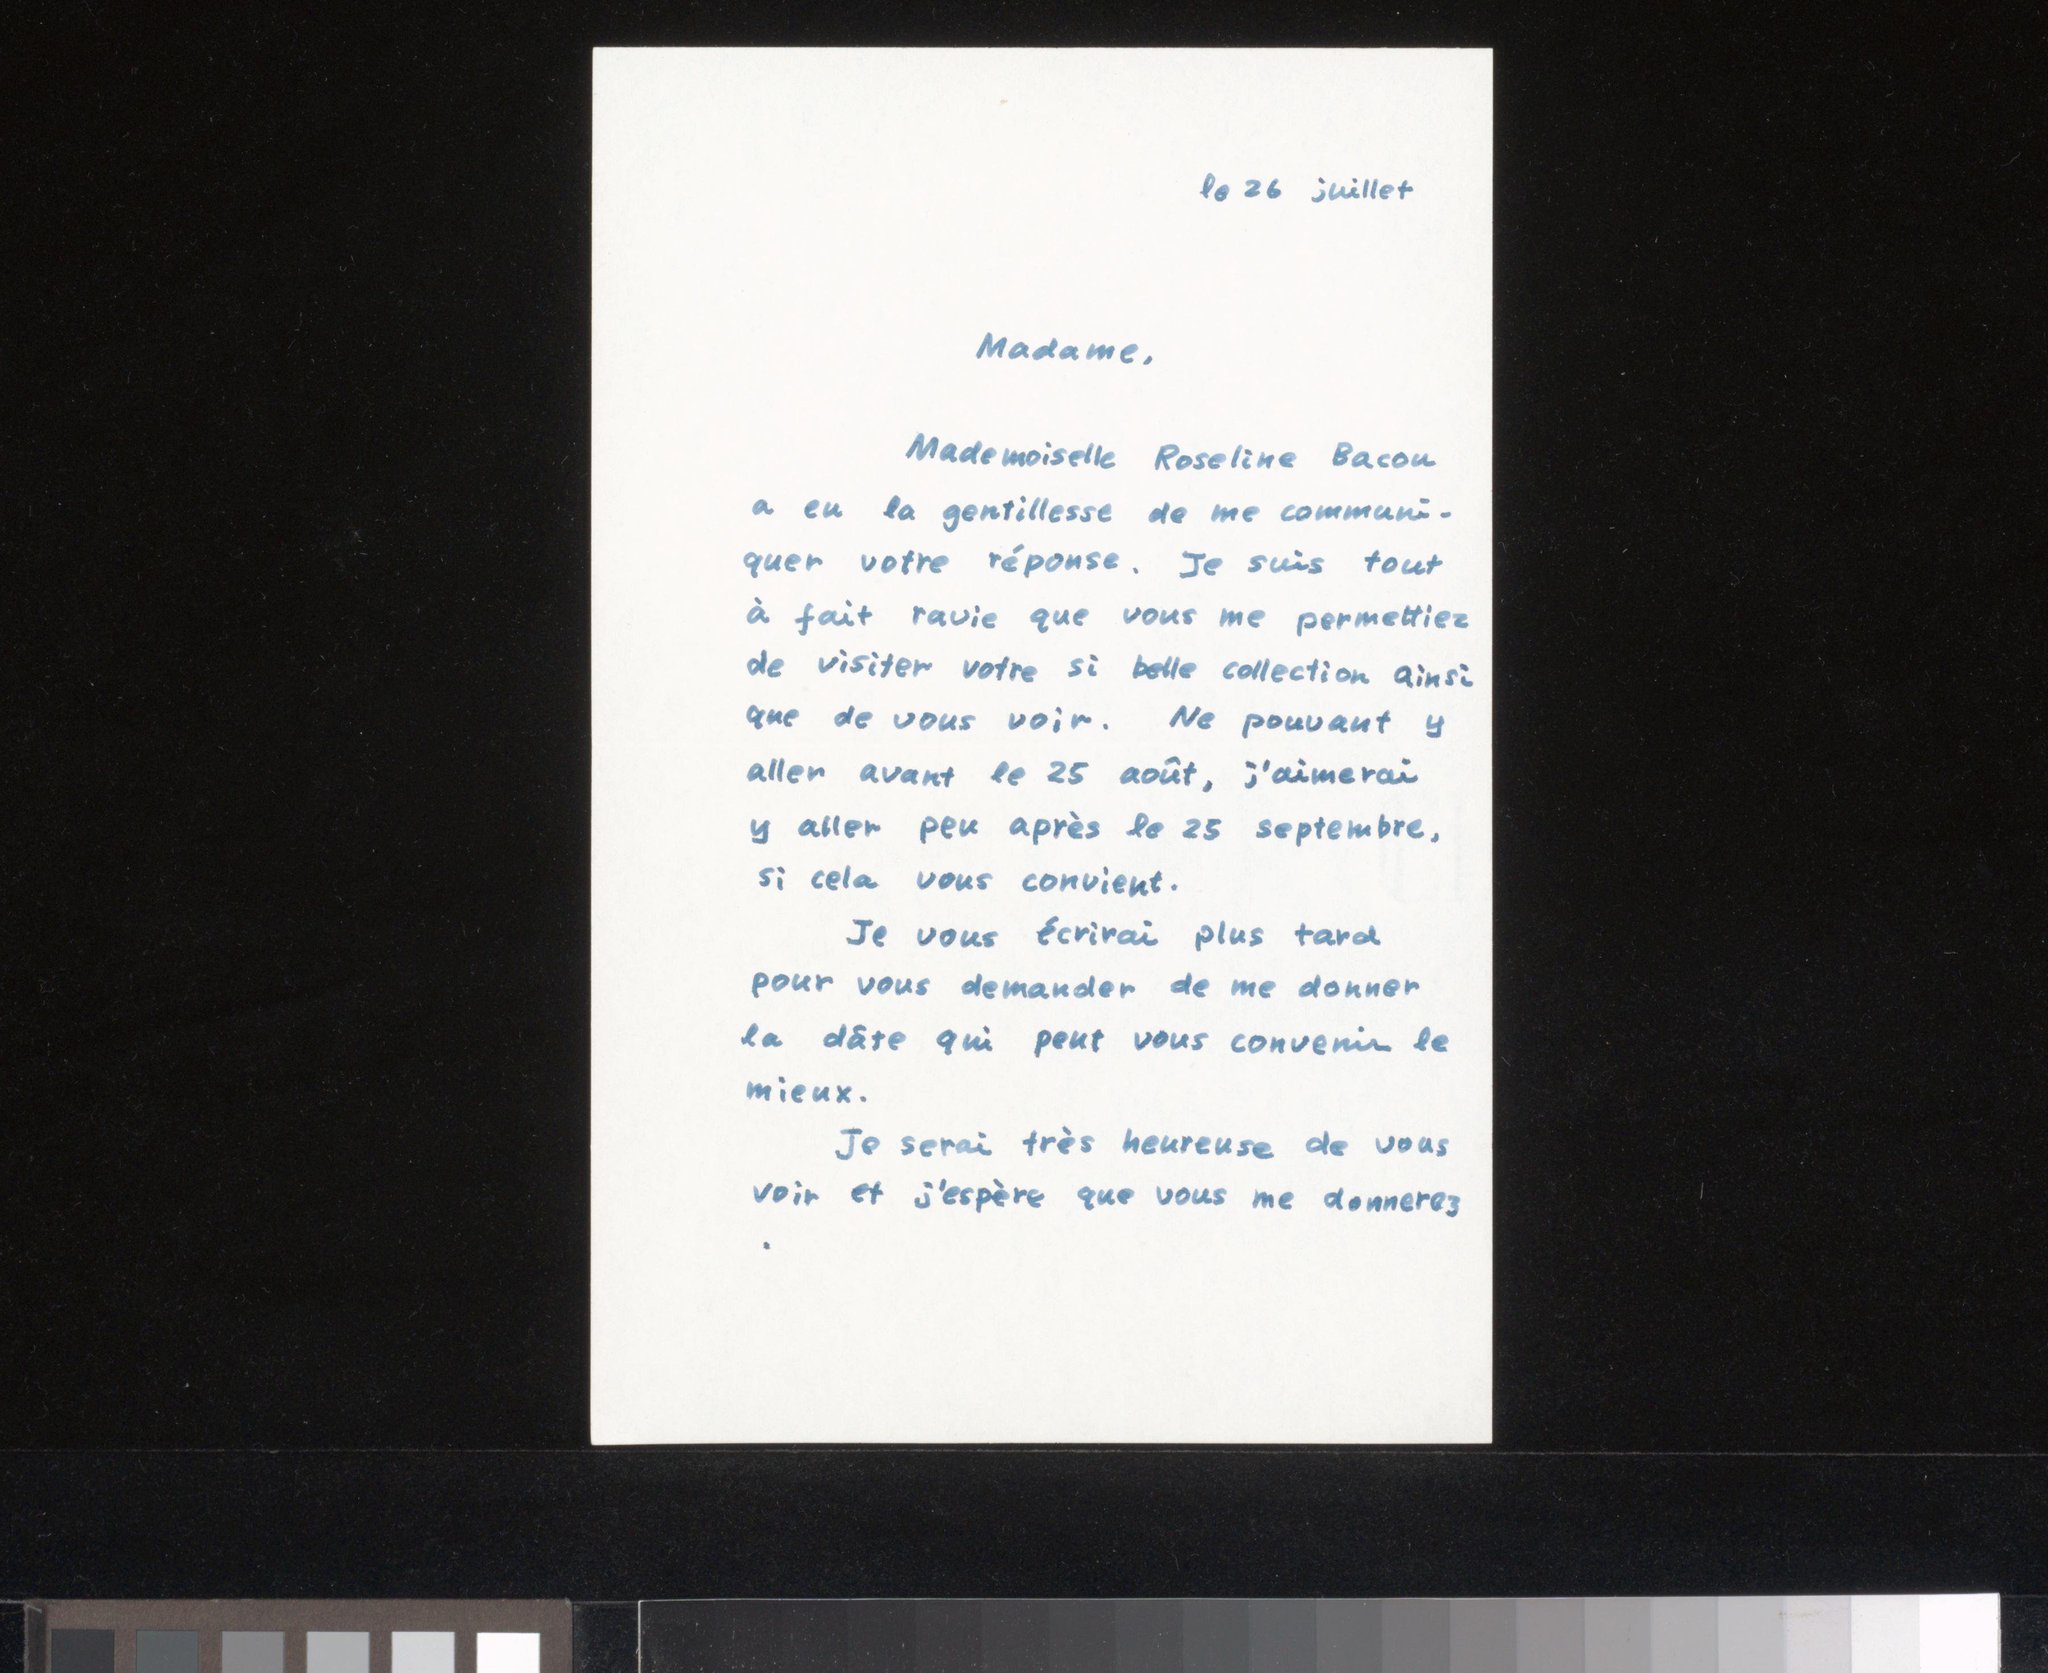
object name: letter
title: Brief aan Françoise W.M. Bonger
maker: gyoko murakami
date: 1969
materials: ink, paper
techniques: pen, writing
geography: paris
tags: roseline bacou, françoise w.m. bonger, art collecting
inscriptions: watermark